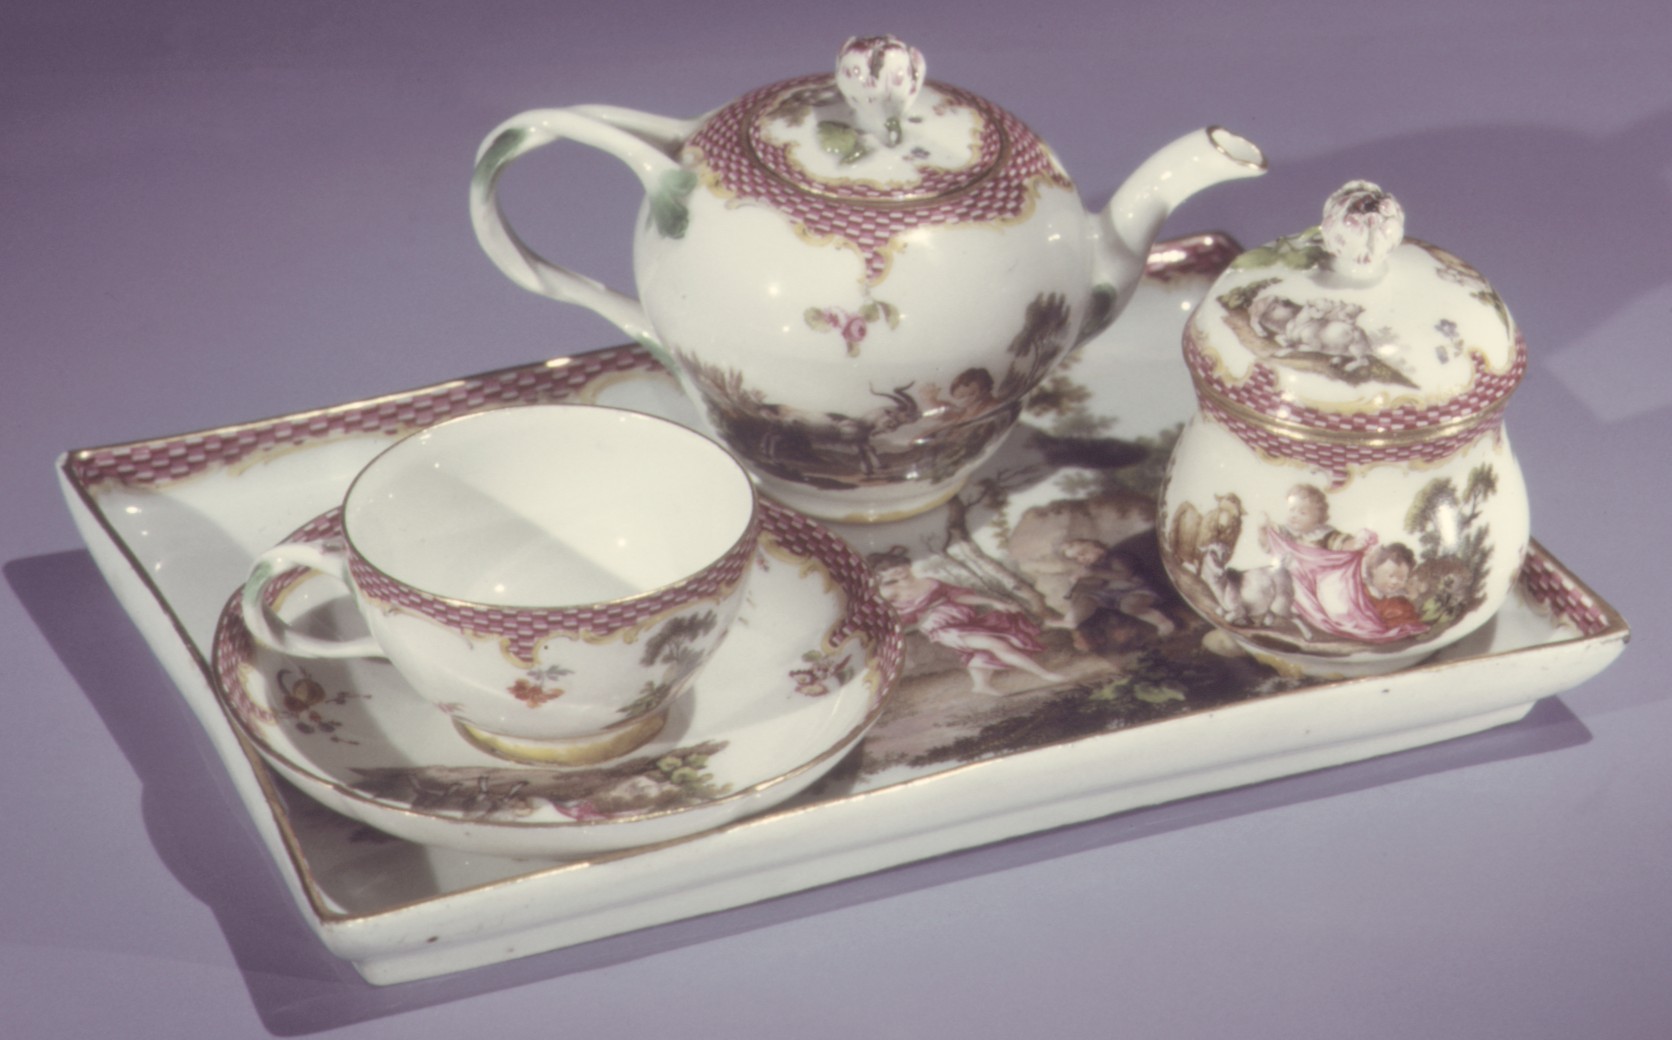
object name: sugar bowl with cover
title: Sugar bowl with cover (part of a set)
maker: meissen manufactory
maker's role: manufactory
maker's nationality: german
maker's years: 1710-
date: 1765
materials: hard paste porcelain